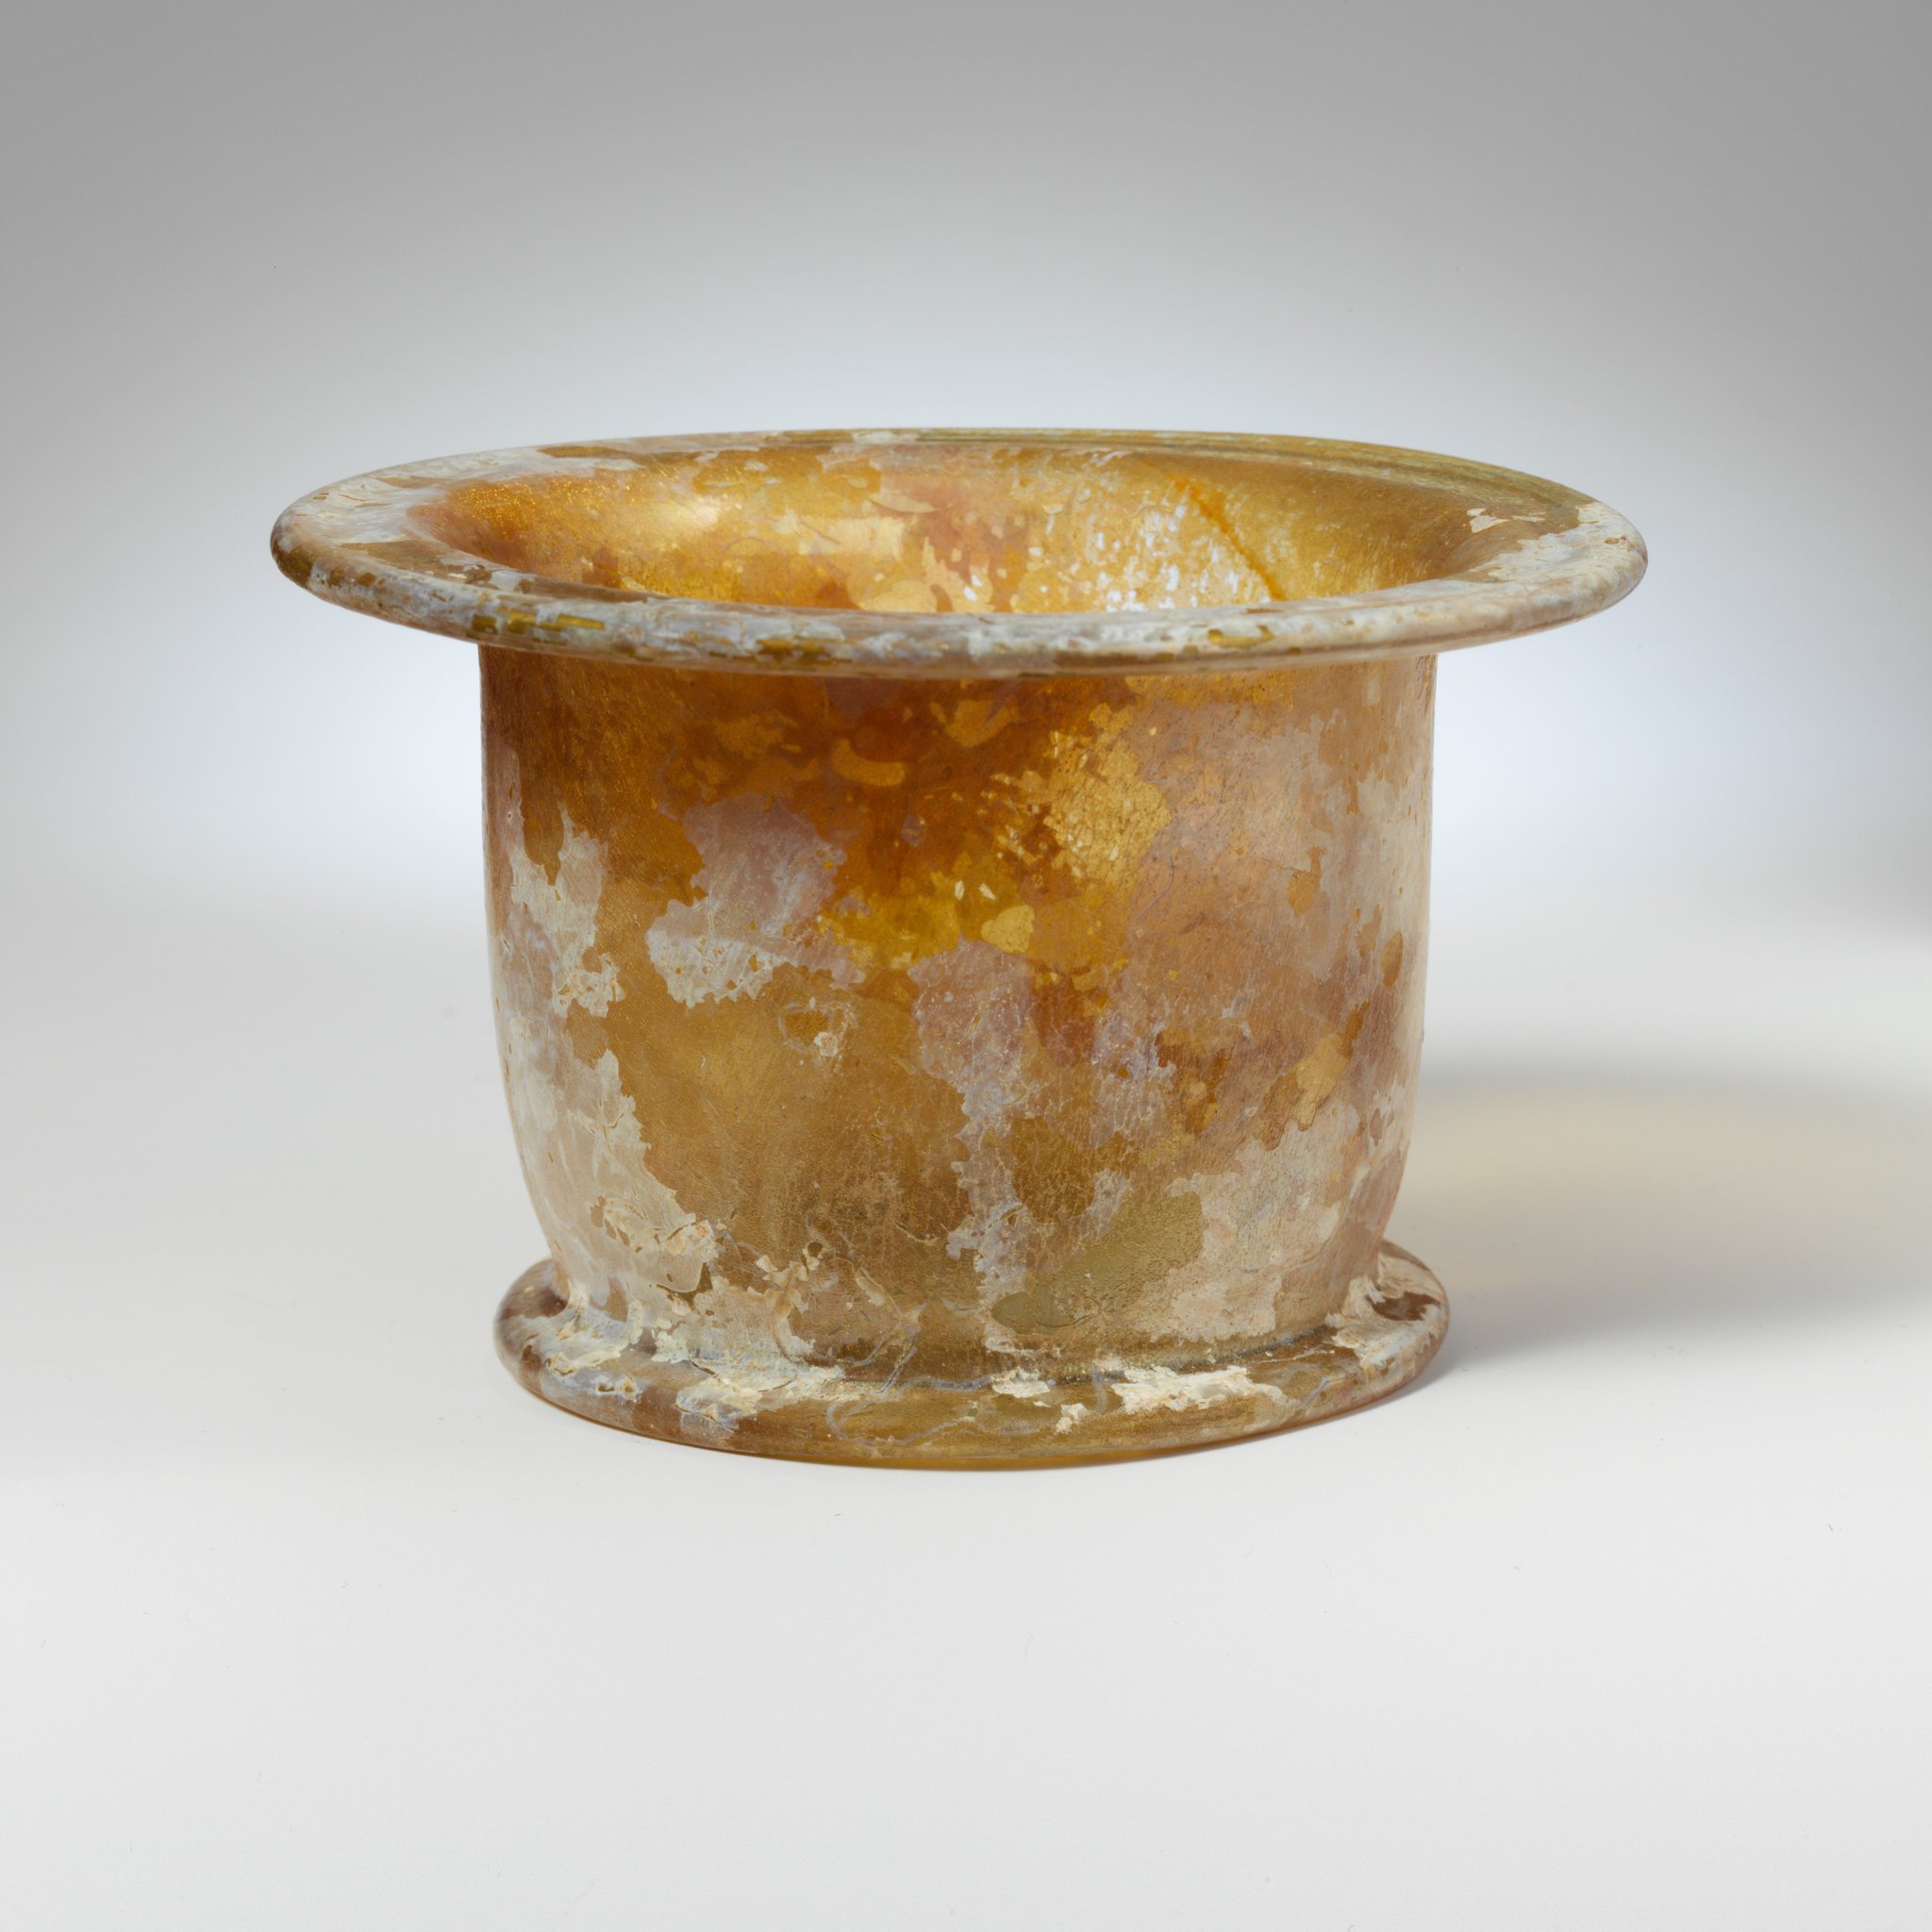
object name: cup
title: Glass cup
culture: roman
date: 101-300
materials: glass